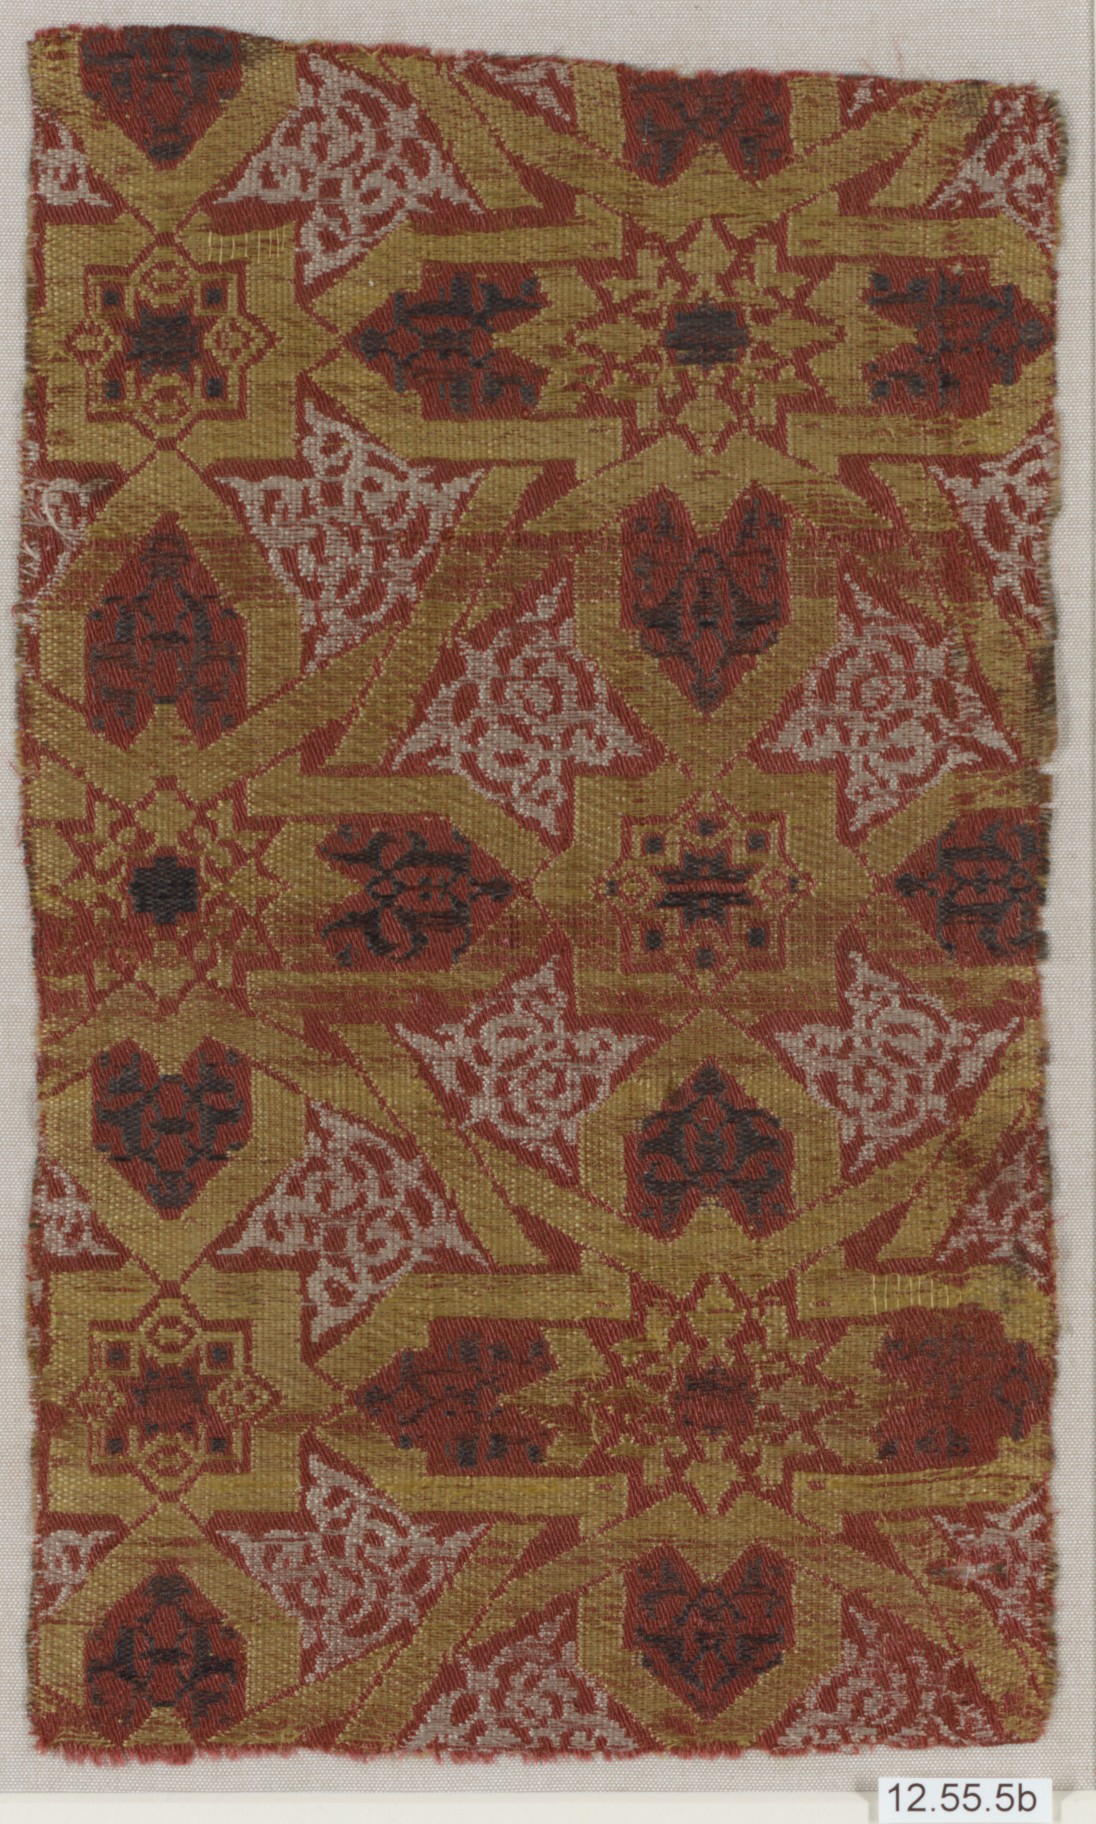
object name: textile fragment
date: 1301-1500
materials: silk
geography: spain